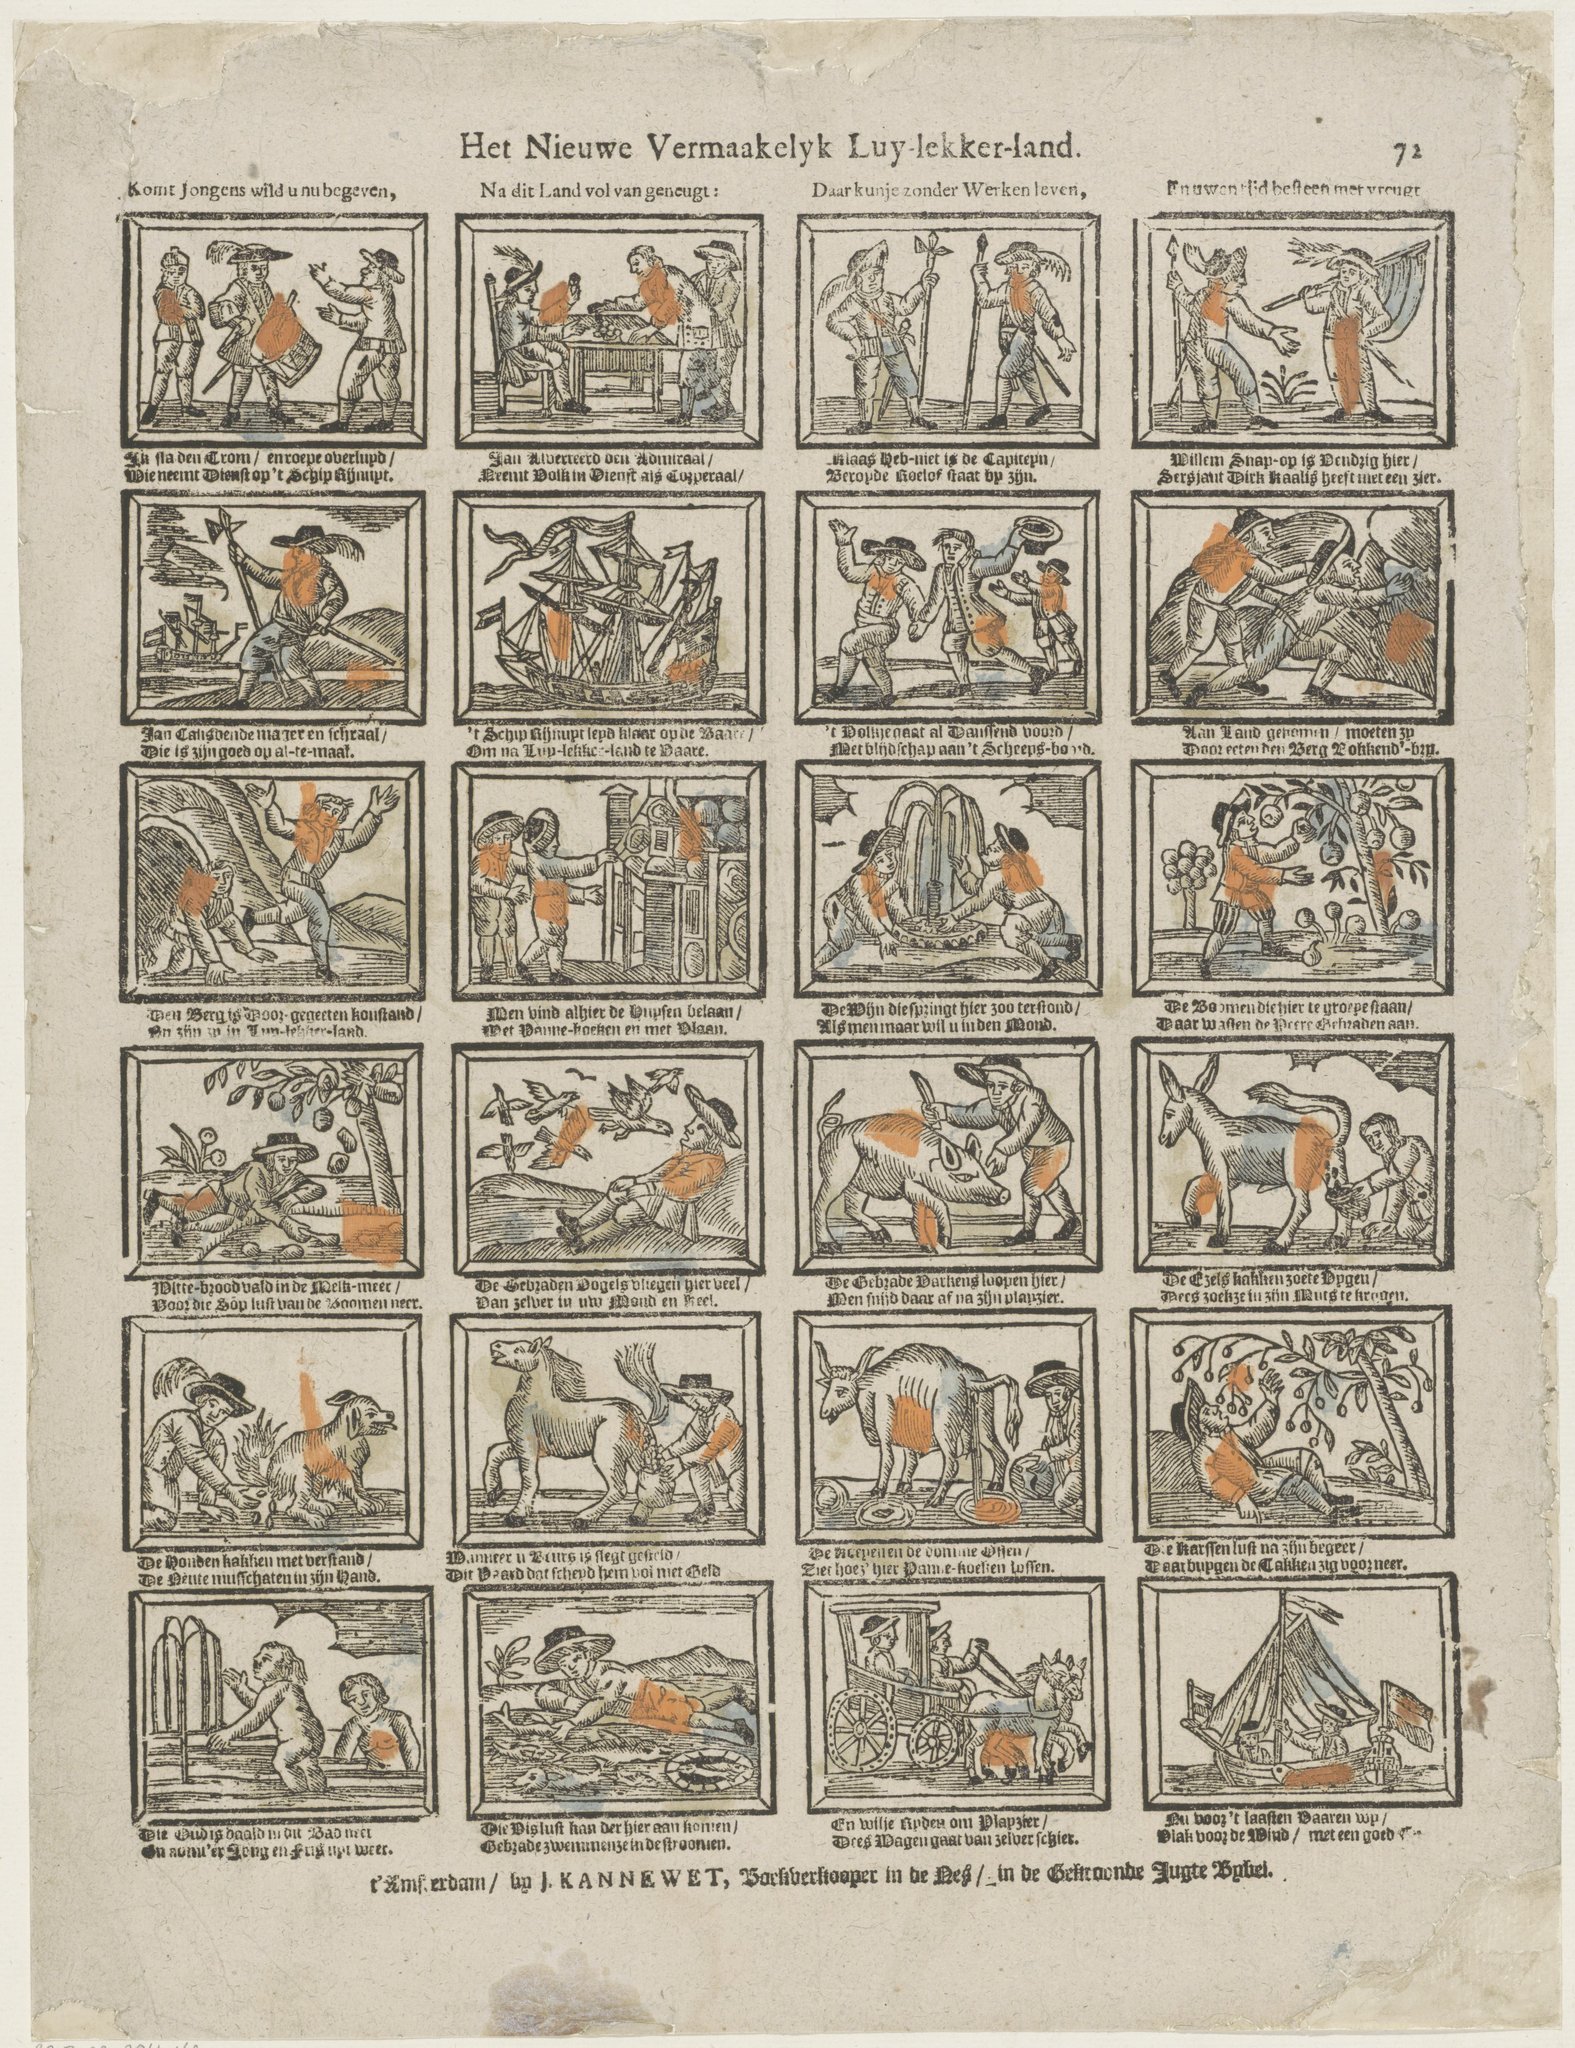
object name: print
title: Het nieuwe vermaakelyk luy-lekker-land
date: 1725-1780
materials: paper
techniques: colour, letterpress printing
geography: amsterdam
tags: land of cockaigne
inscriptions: collector's mark: Lugt 2760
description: Blad met 24 voorstellingen van het Luilekkerland. Onder elke afbeelding een tweeregelig vers. Genummerd rechtsboven: 72.